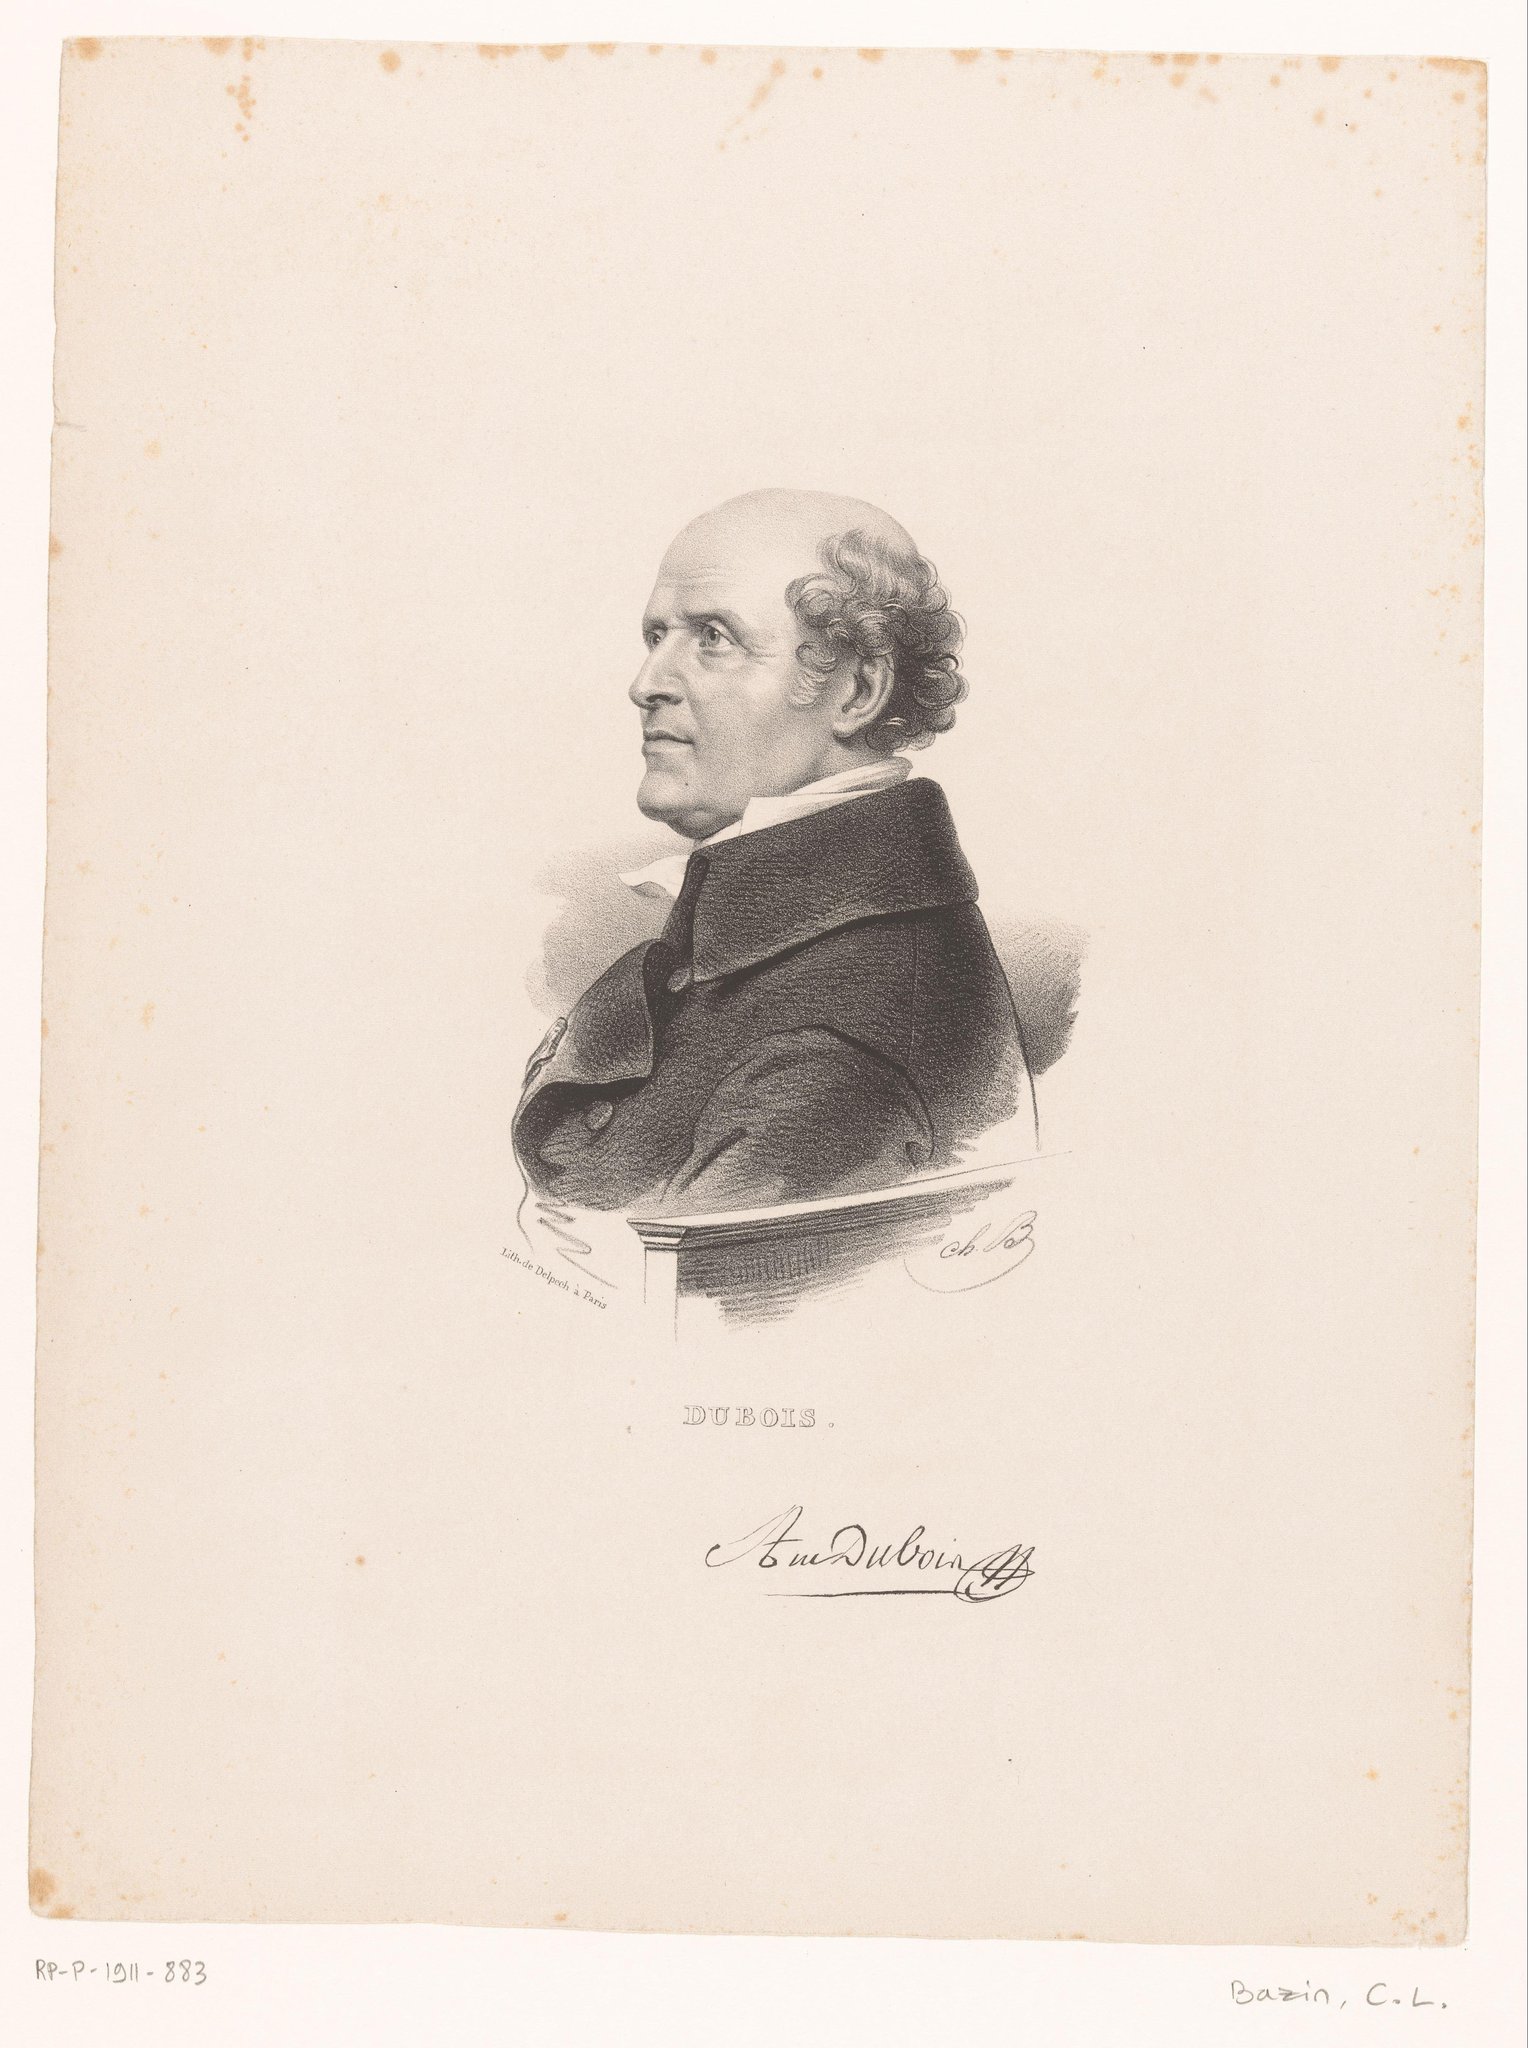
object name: print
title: Iconographie des contemporains depuis 1789 jusqu'à 1820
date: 1830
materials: paper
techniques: lithograph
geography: paris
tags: paris, historical persons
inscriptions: collector's mark: Lugt 2228a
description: De serie Iconographie des contemporains depuis 1789 jusqu'à 1820 is uitgegeven tussen 1822 en 1833 in verschillende livraisons.